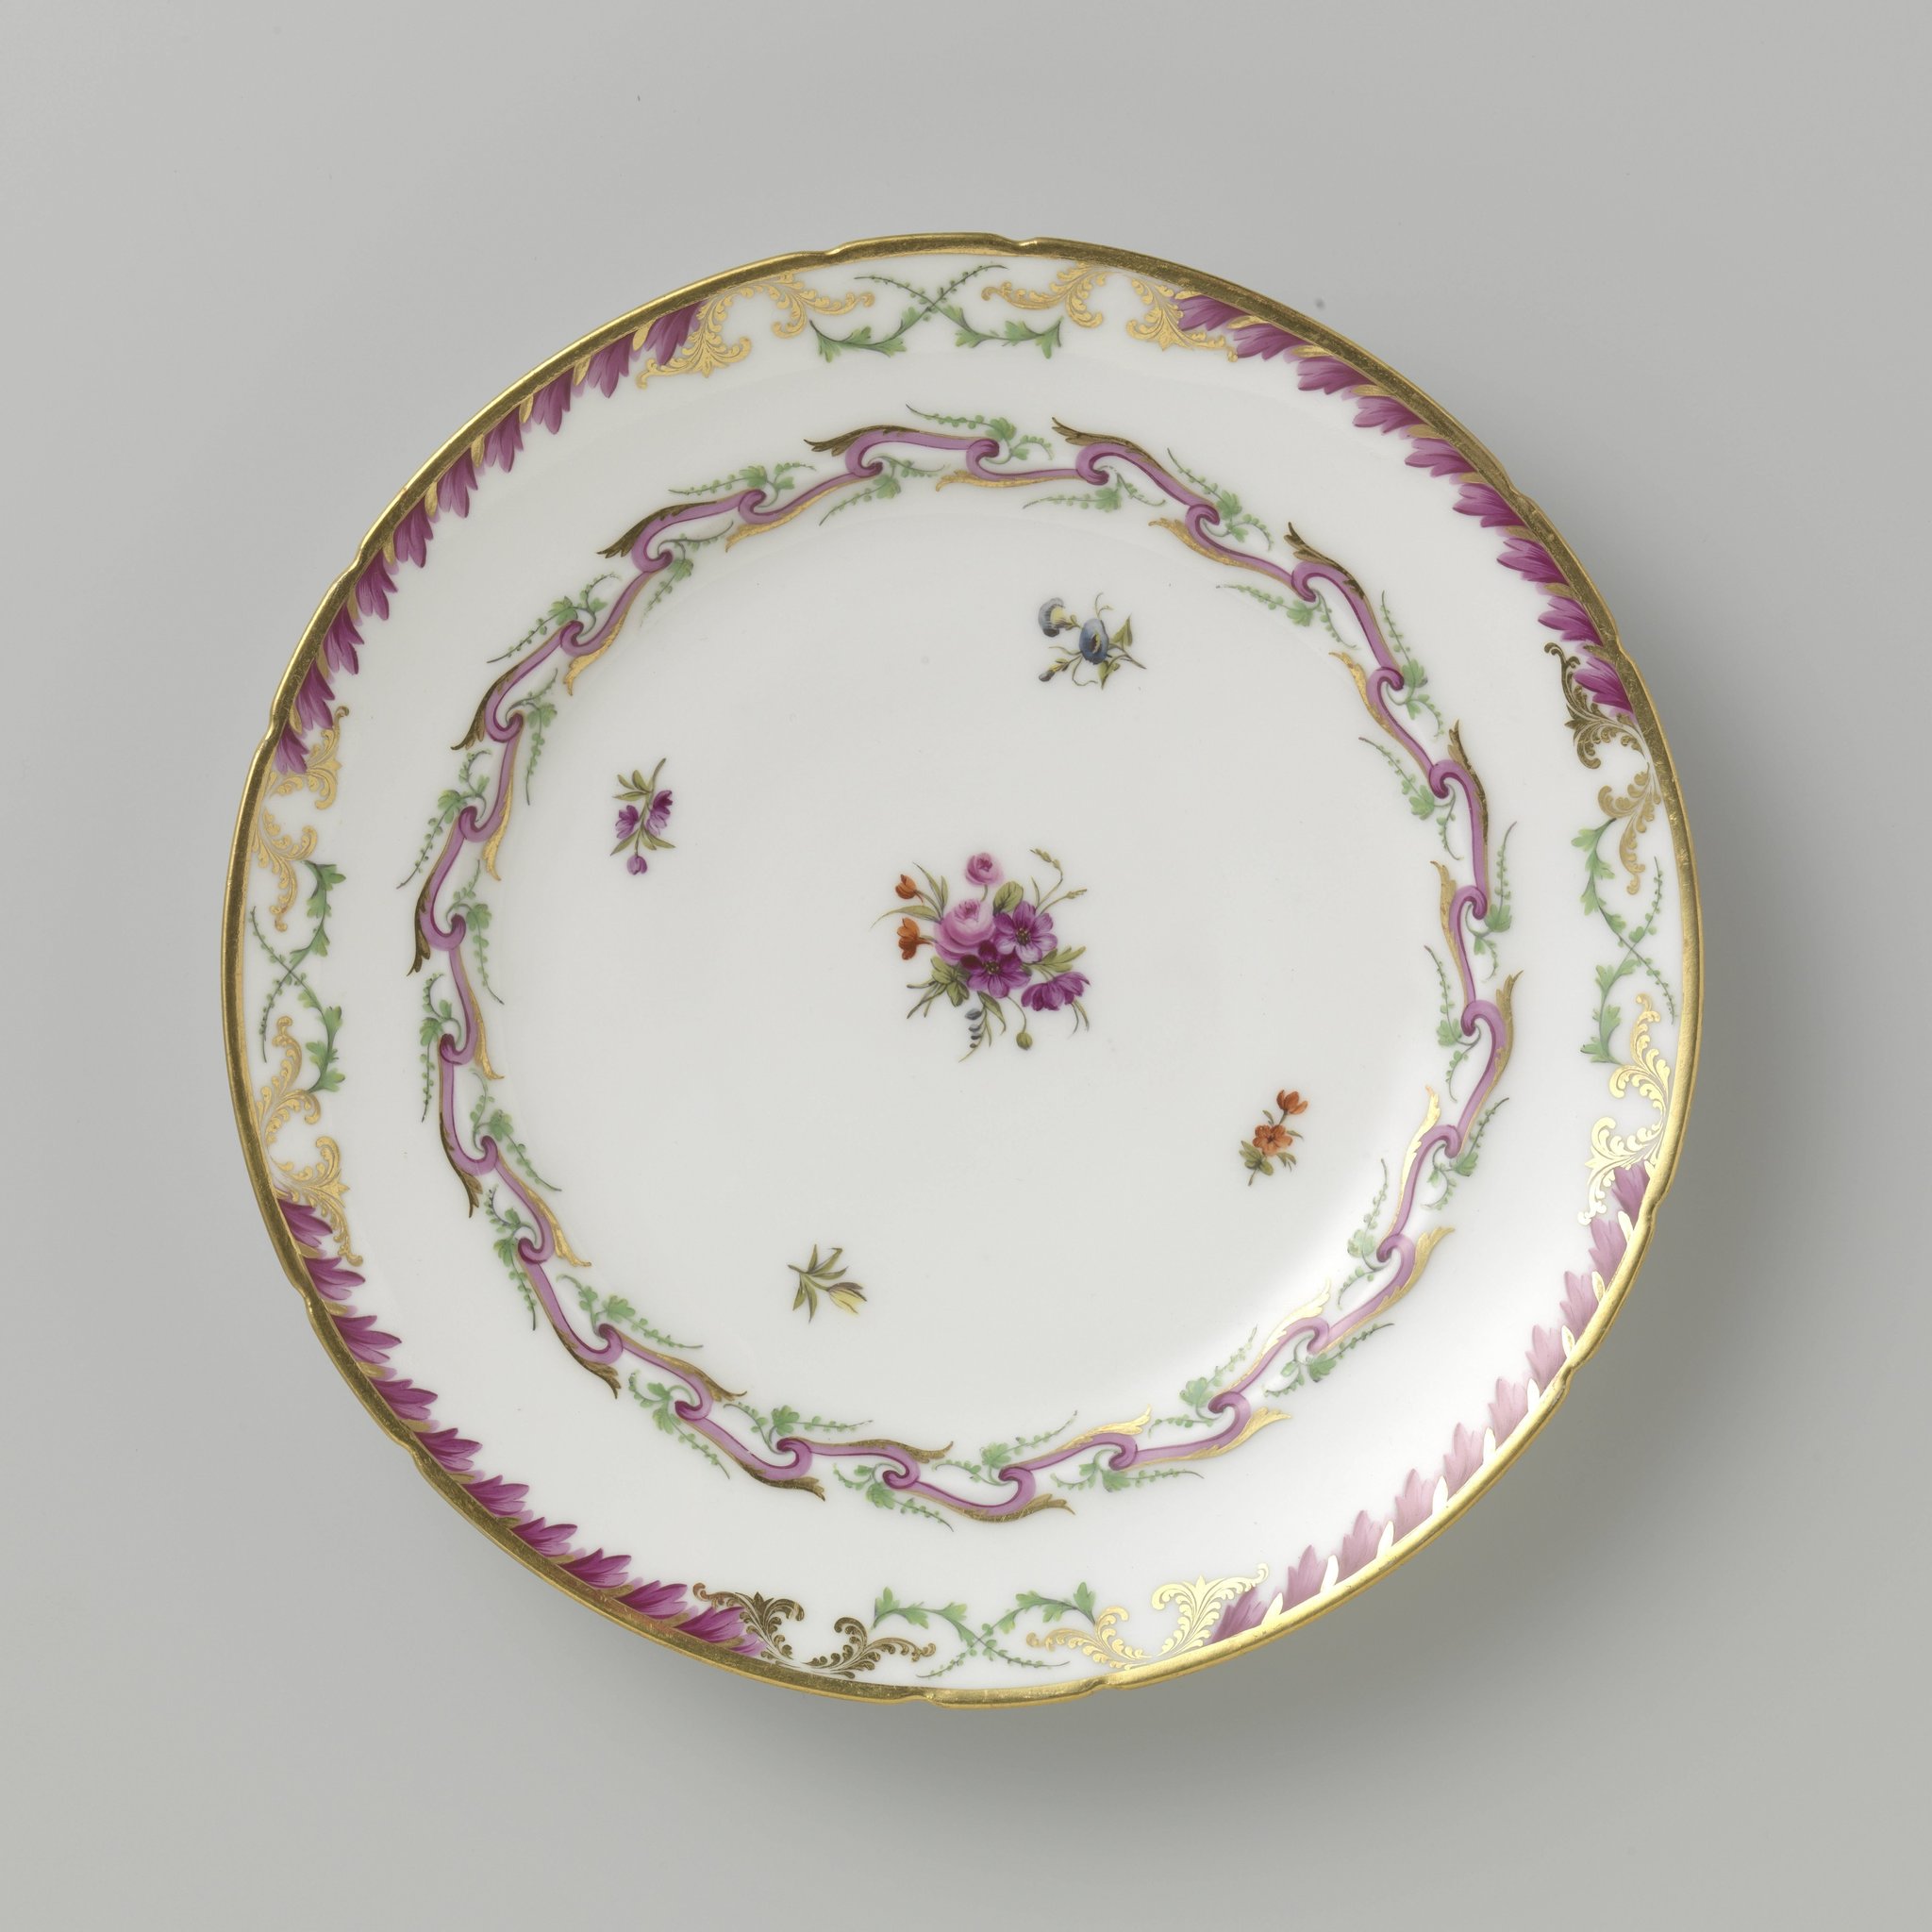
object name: plate dish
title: Bord, plat model, behorend bij een servies met geslingerd lintmotief met bladertakken, bloemboeketten en gestrooide bloemtakken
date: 1780-1820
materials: porcelain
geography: amsterdam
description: Bord, plat model, behorend bij een servies van porselein met geslingerd lintmotief in paars en goud met groene bladertakken, bloemboeketten en gestrooide bloemtakken. Randen lichtgegolfd met decoratie in goud met paars bladmotief waartussen groen gekruist bladmotief. Gemerkt: M.O.L. of AMSTEL.